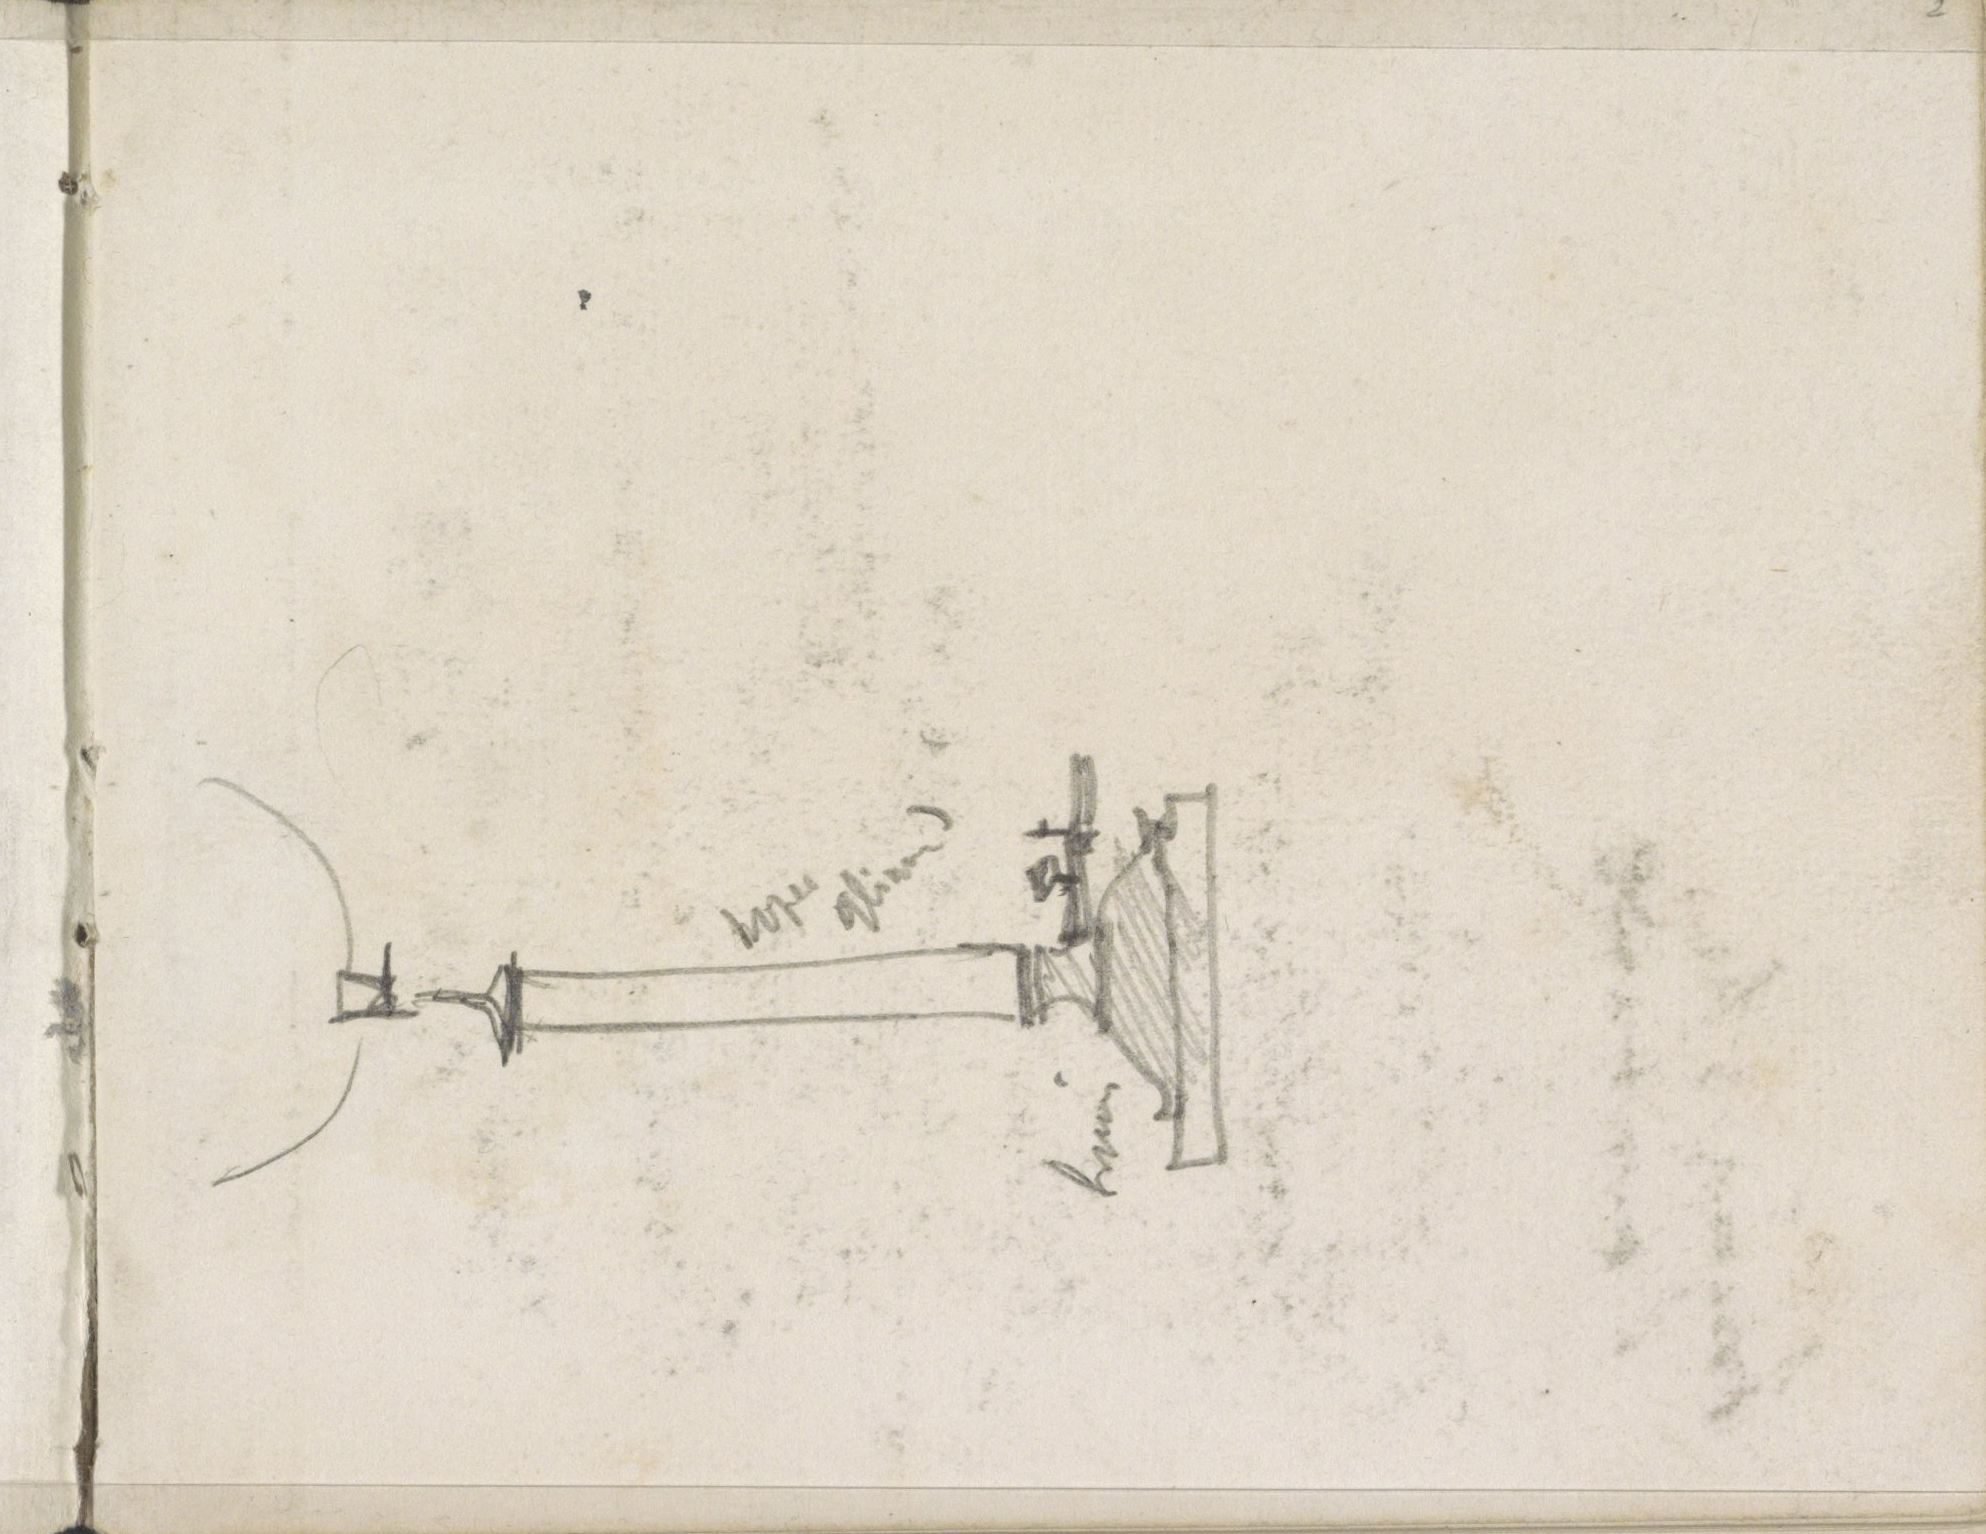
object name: sketchbook leaf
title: Koperen lampvoet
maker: george hendrik breitner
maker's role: draughtsman, painter, print maker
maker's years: 1857-1923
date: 1908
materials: paper, pencil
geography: amsterdam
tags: gas-lamp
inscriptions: annotation: ‘koper/ glimmend/ [...]’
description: Pagina 2 uit een schetsboek met 23 bladen.